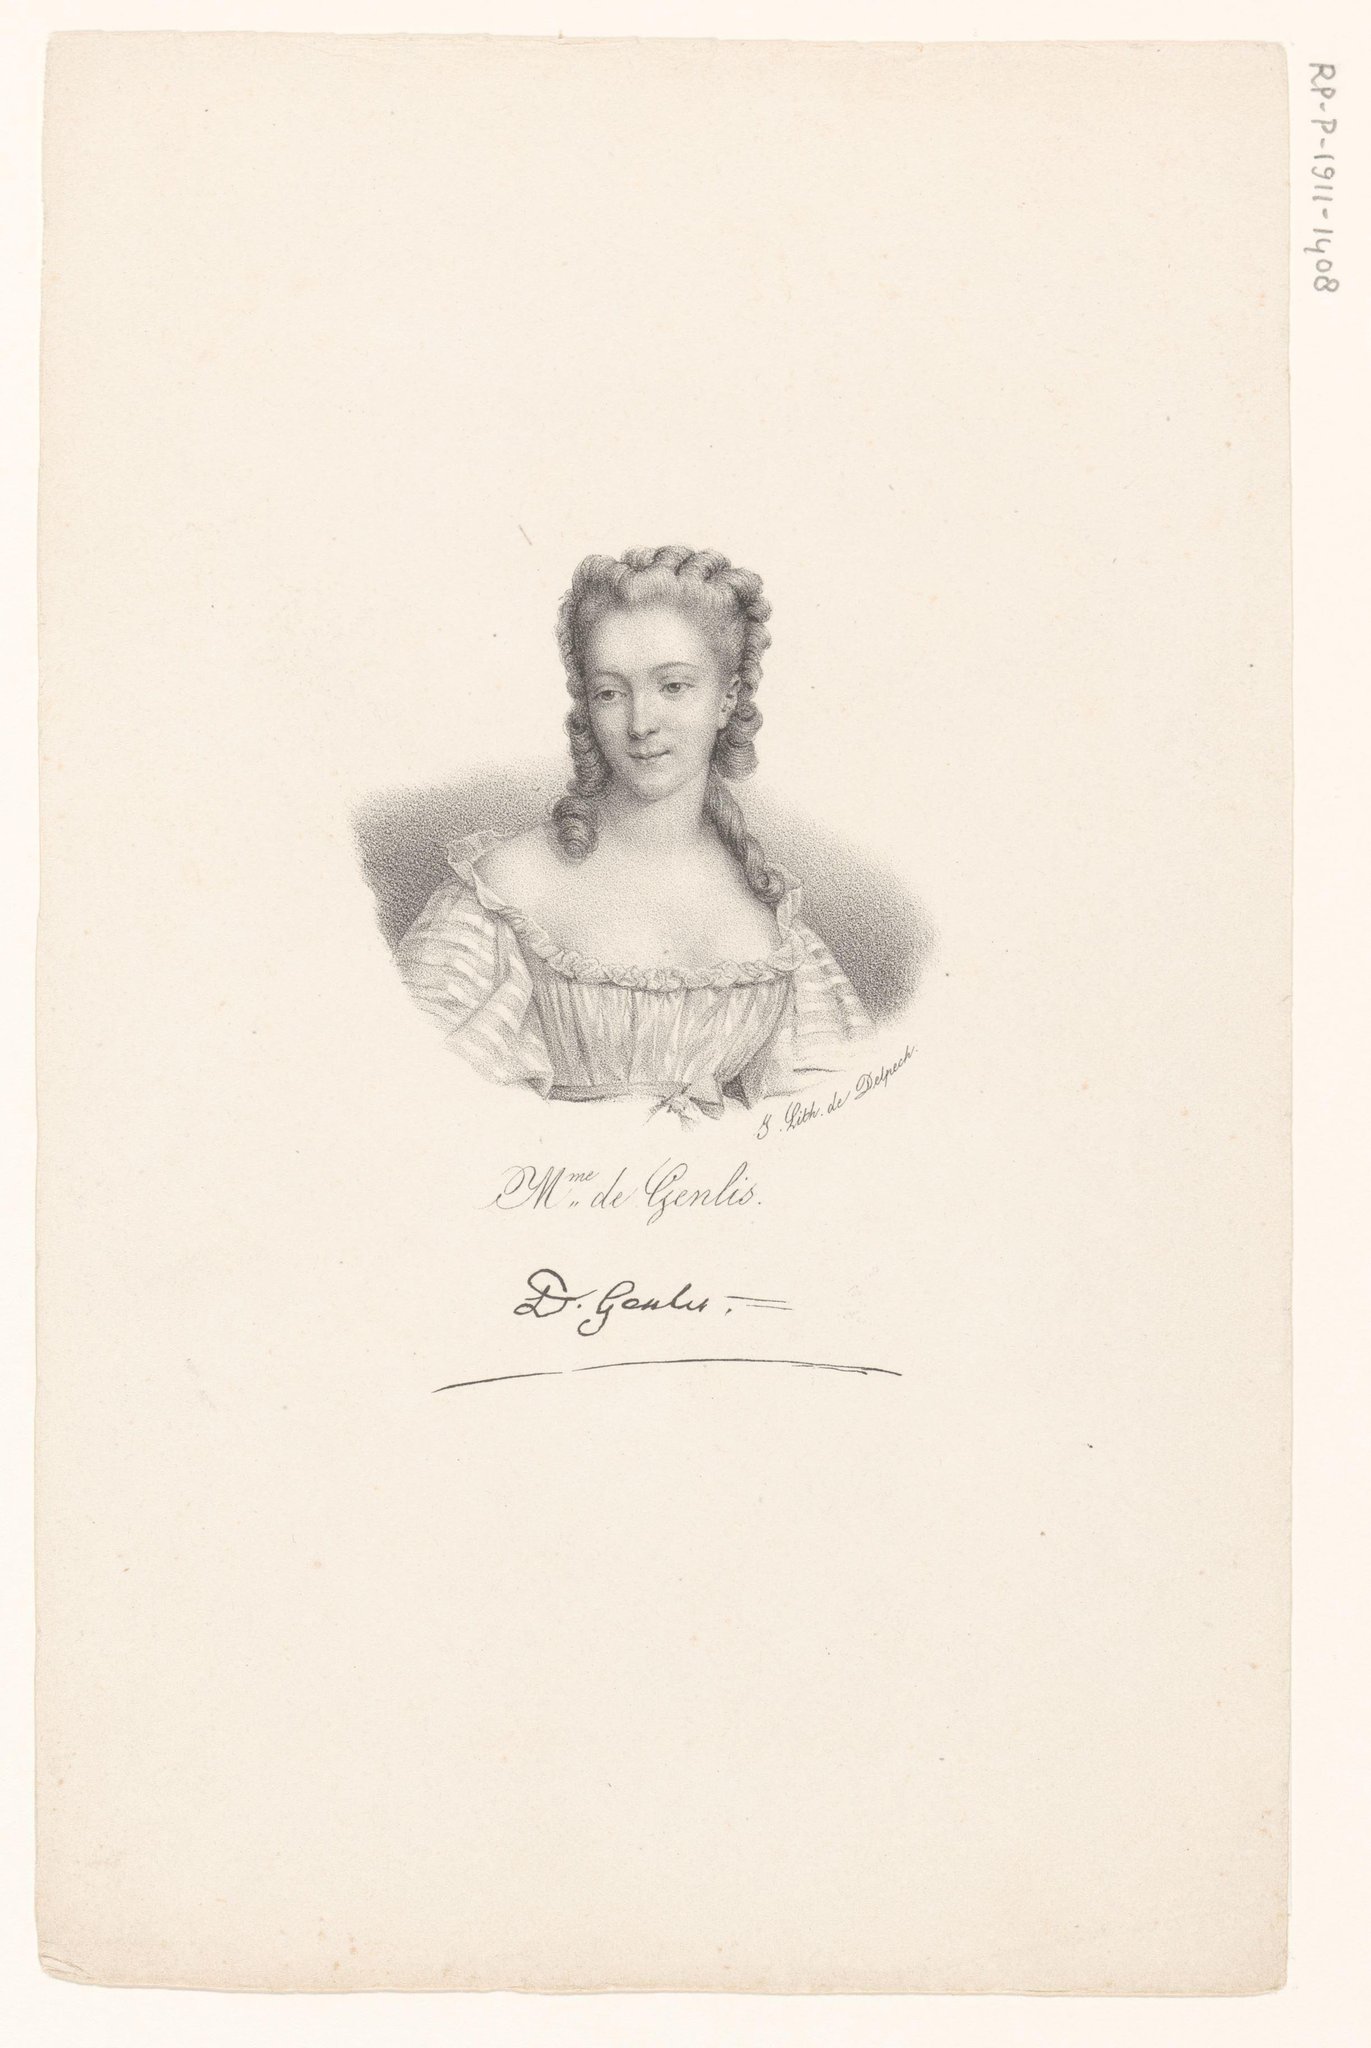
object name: print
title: M.me de Genlis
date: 1818-1842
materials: paper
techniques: lithograph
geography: paris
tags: paris, historical persons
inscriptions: collector's mark: Lugt 2228a